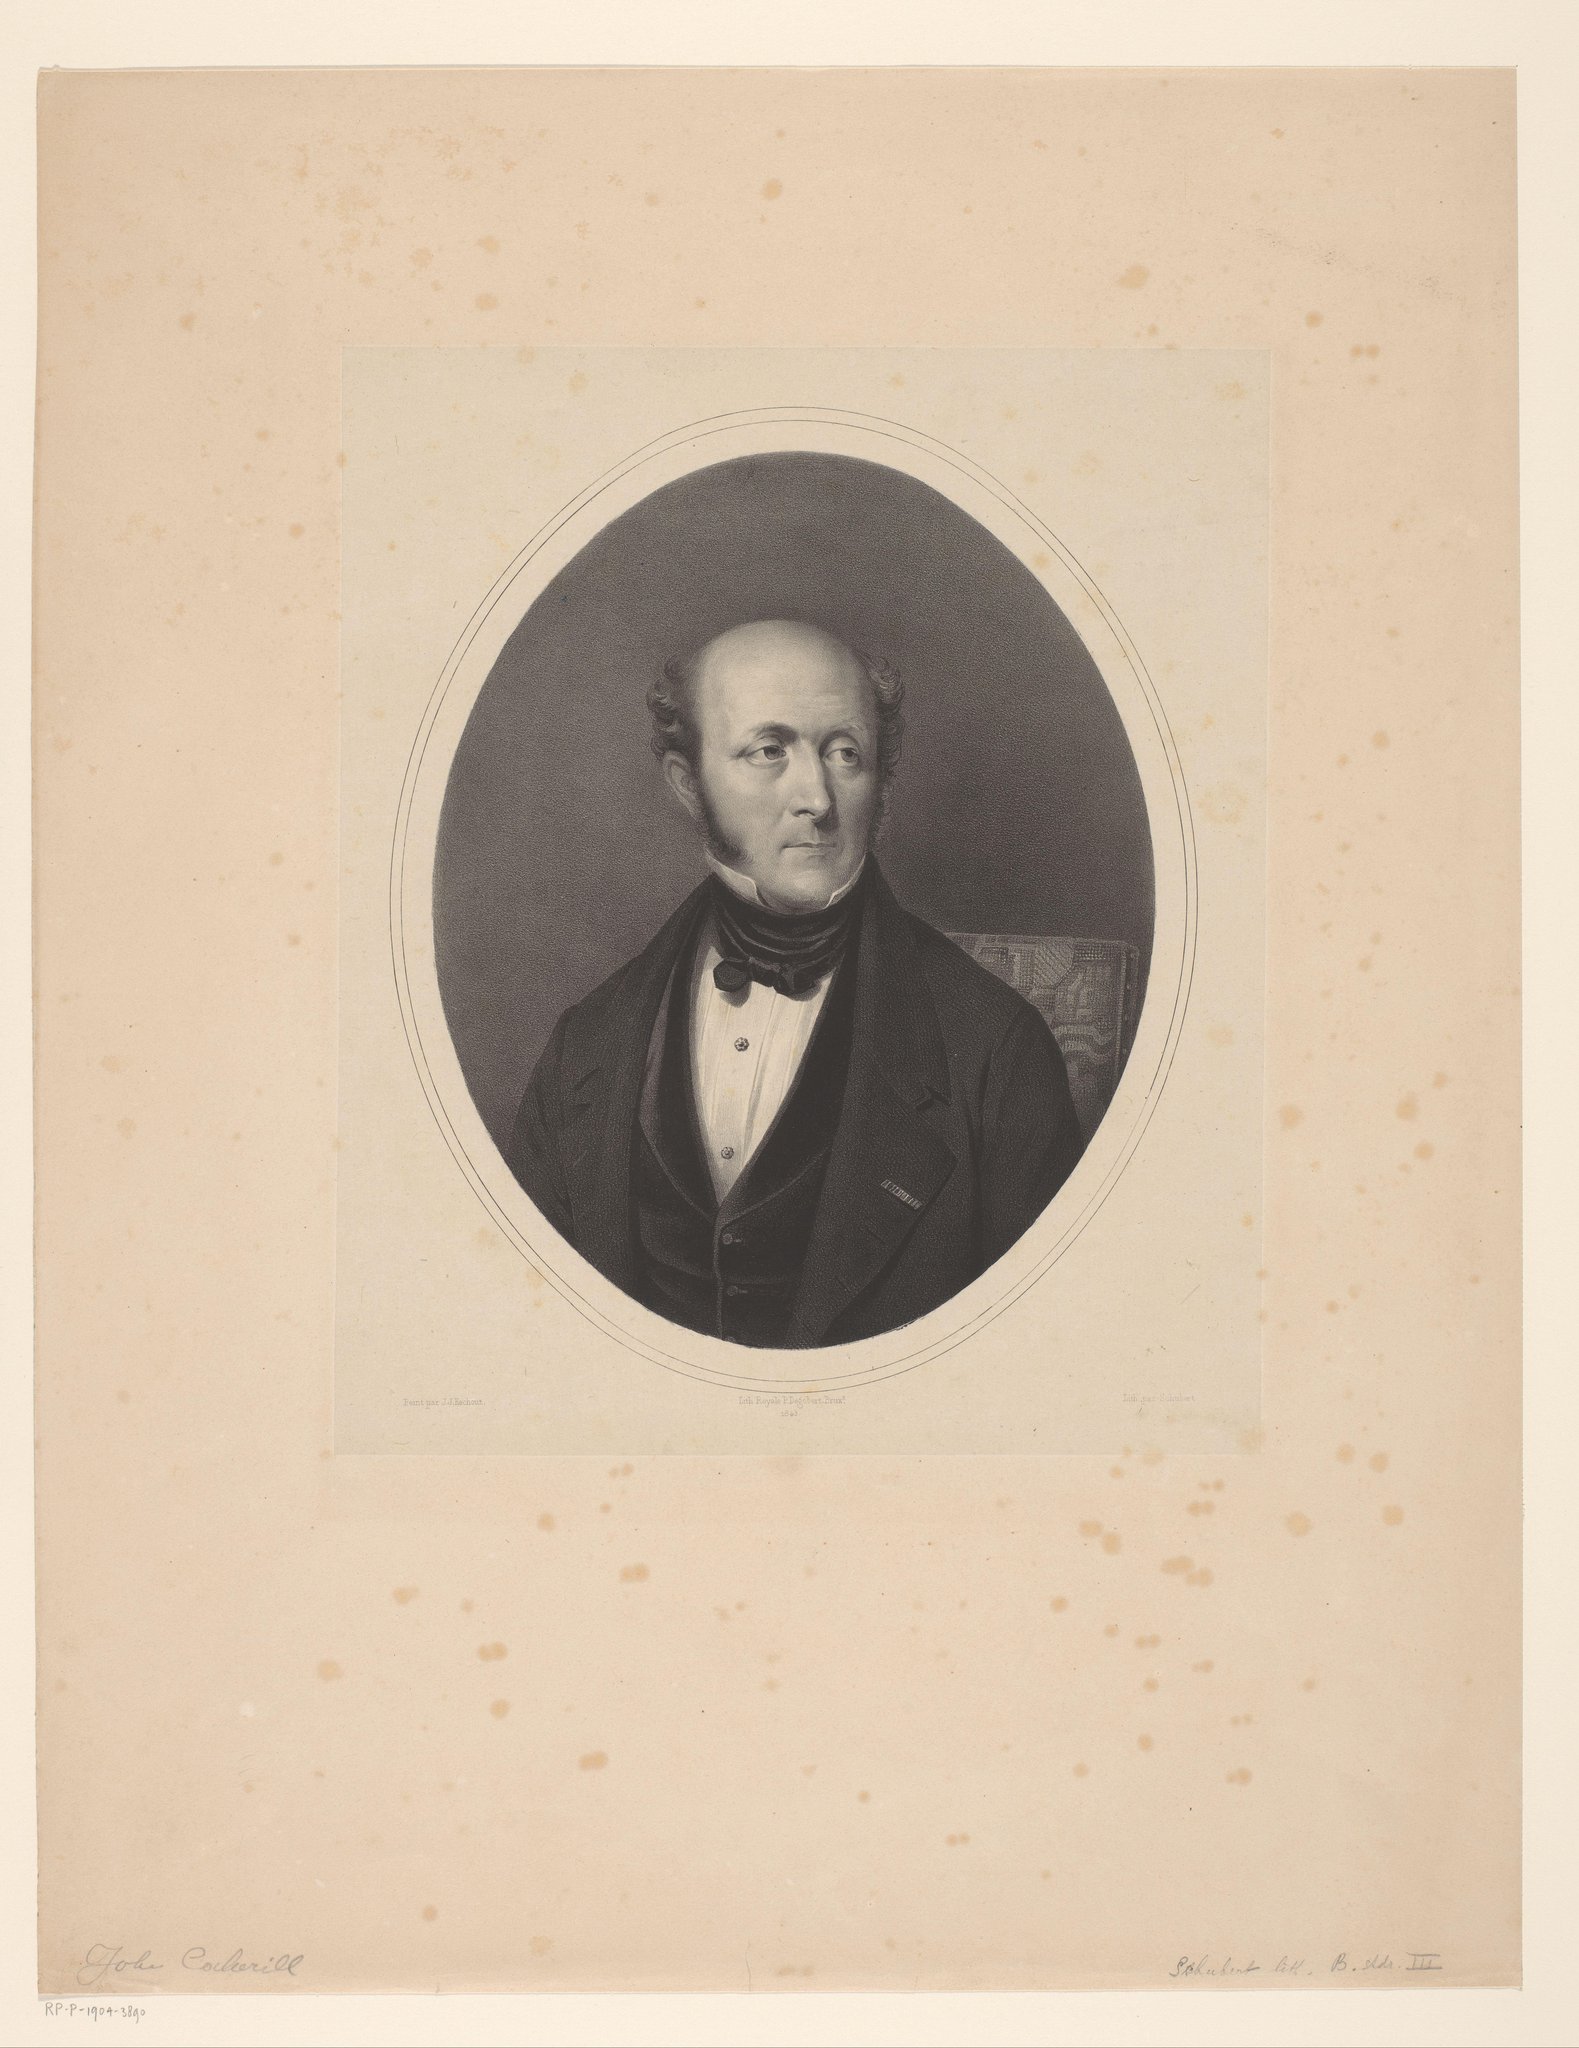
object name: print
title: Portret van een onbekende man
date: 1843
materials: paper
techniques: lithograph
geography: brussels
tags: historical persons not known by name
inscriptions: collector's mark: Lugt 2228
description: In het inventarisboek wordt "Franc. Theod. Everard" vermeld als de geportretteerde, op de prent zelf staat een aantekening met de naam "John Cockerill". Voor beide namen is echter geen bewijs te vinden.